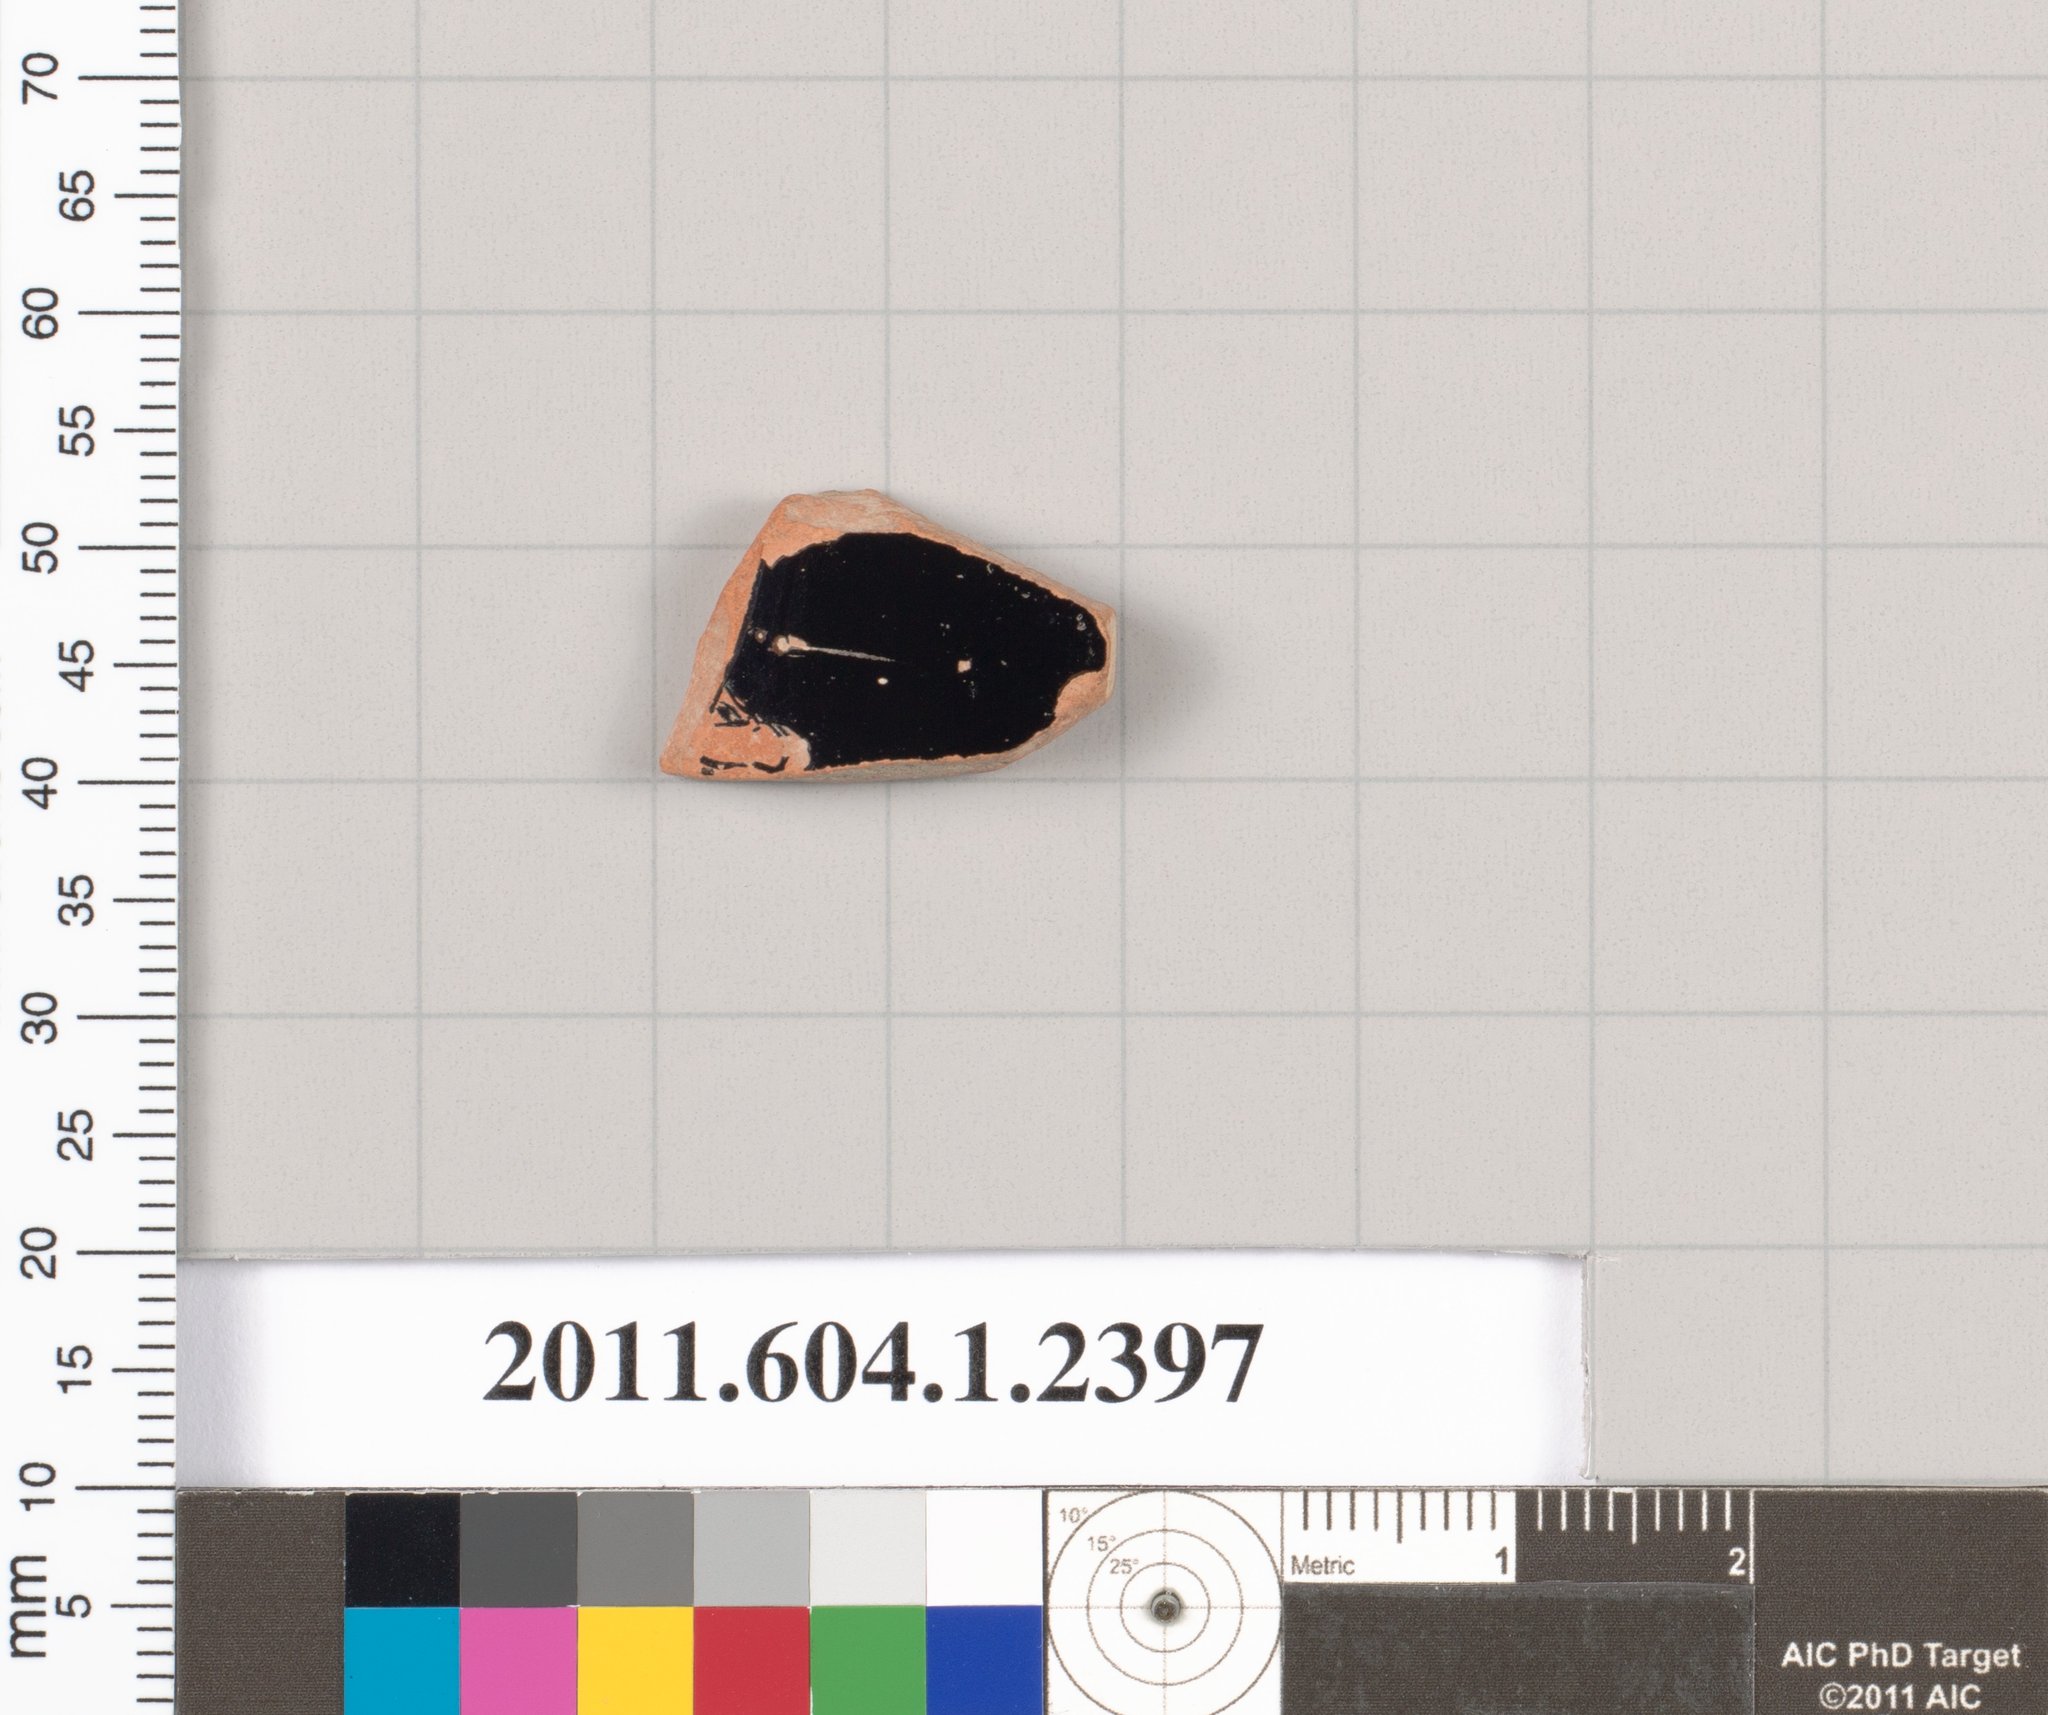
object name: kylix fragment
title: Terracotta fragment of a kylix (drinking cup)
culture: greek, attic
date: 475-451 BCE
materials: terracotta